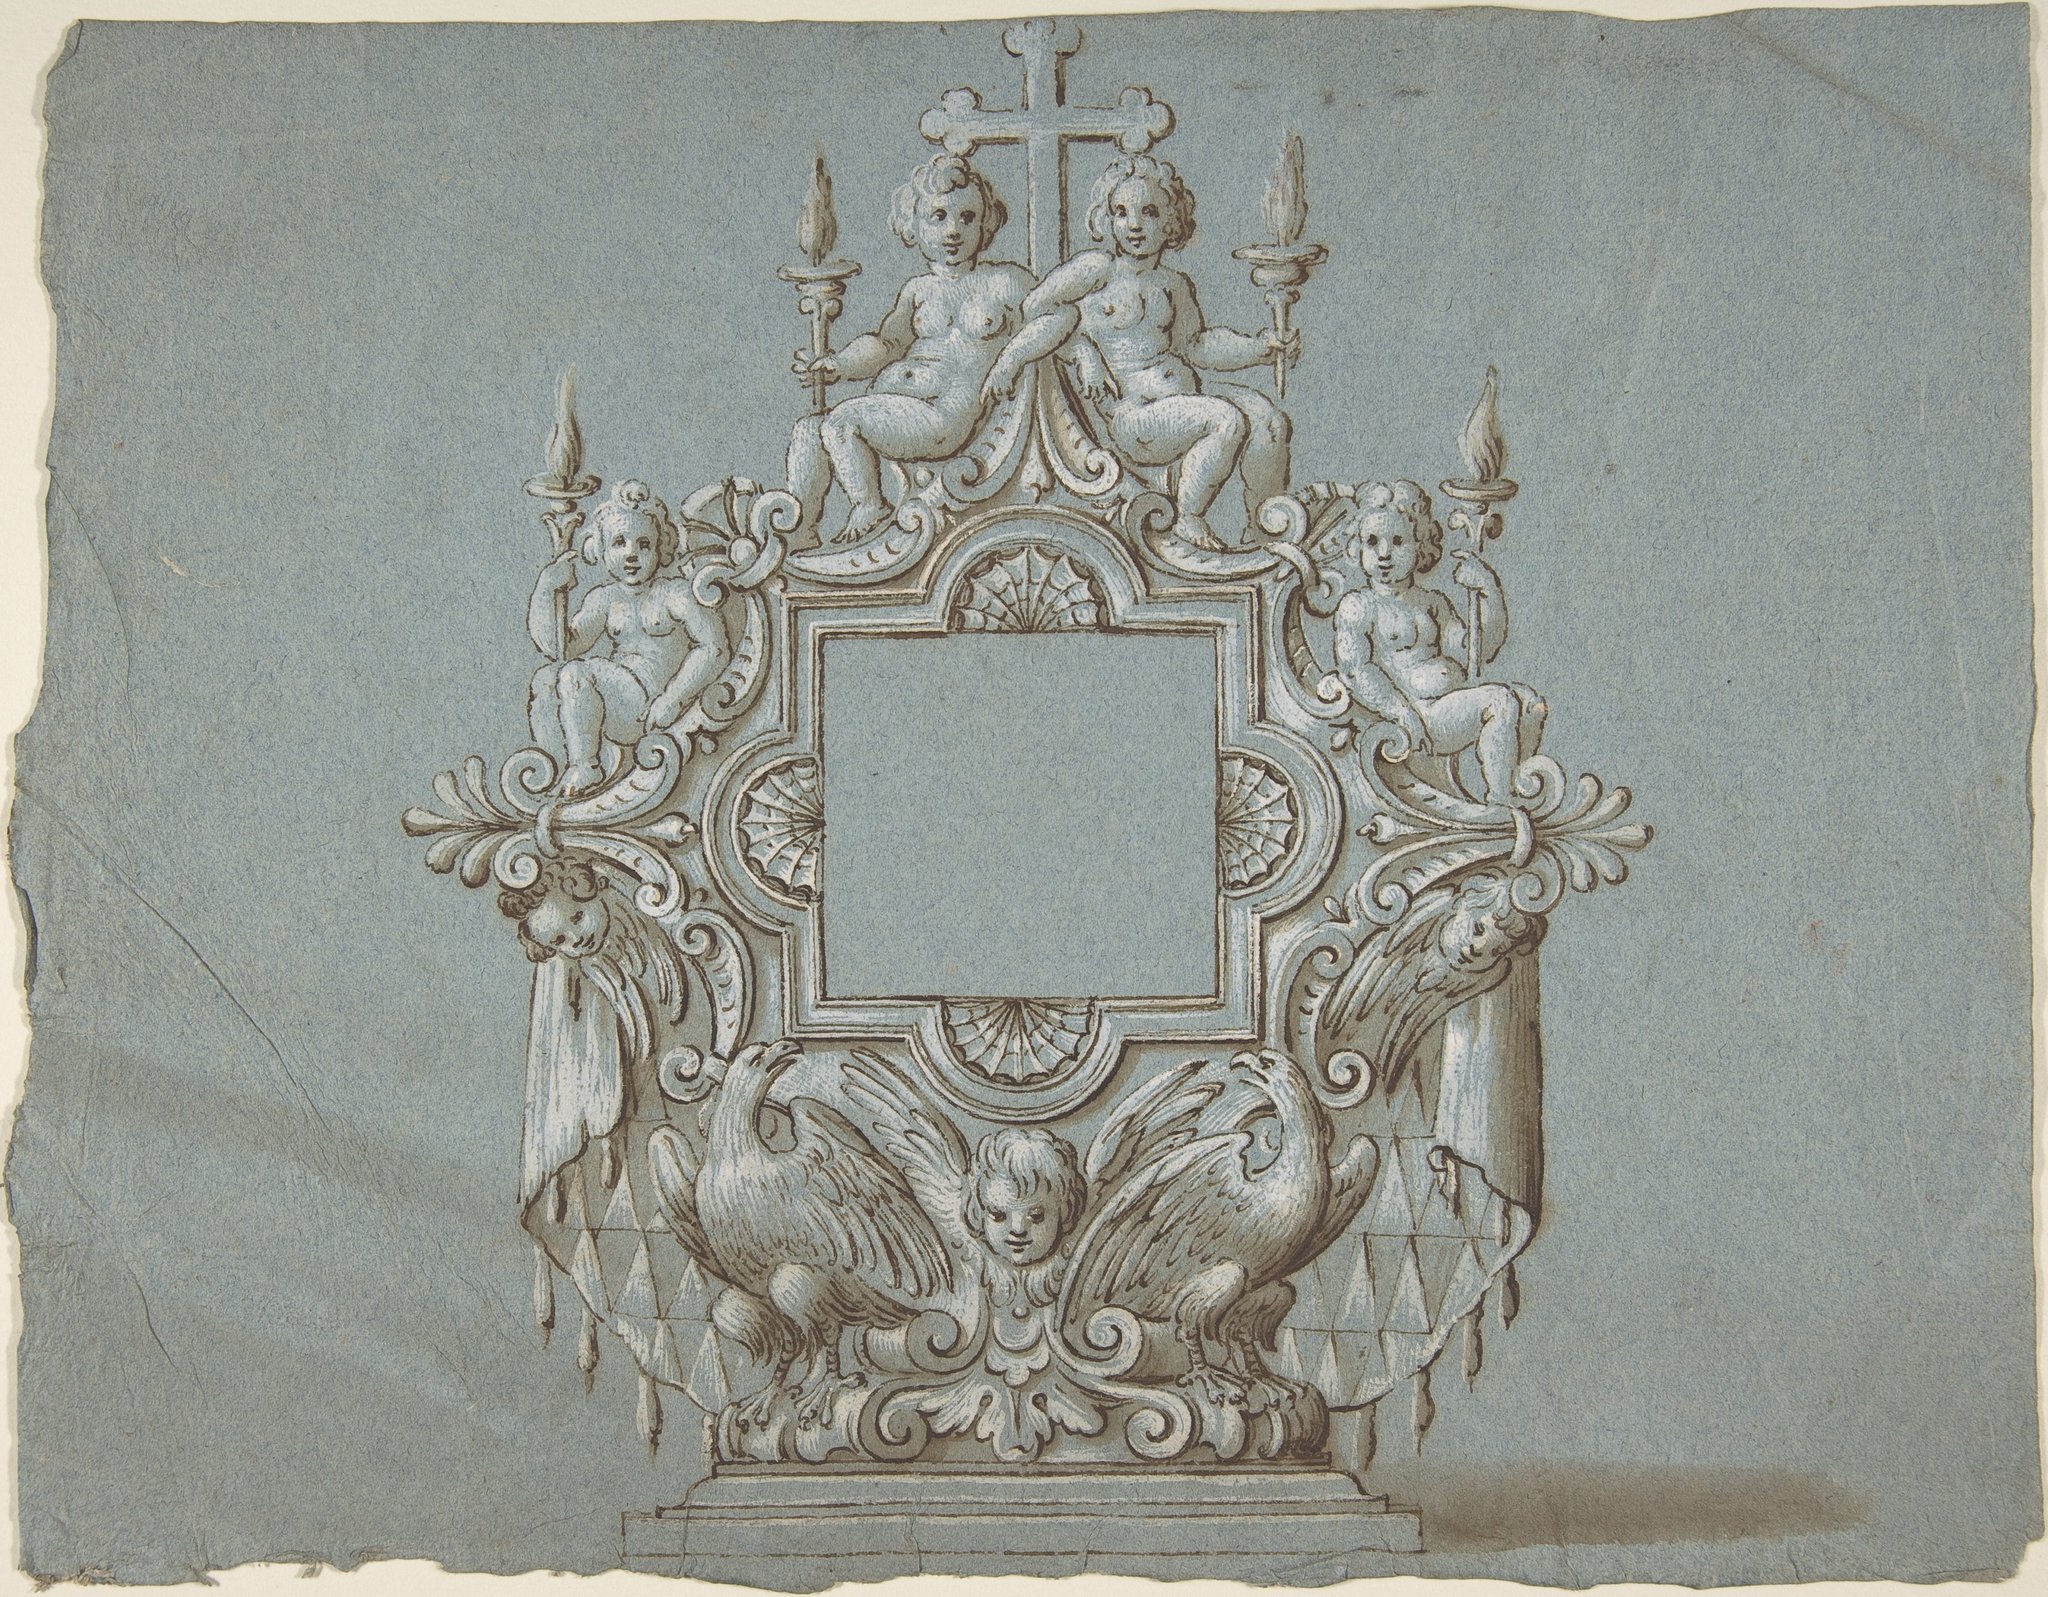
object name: drawing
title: Ornamental design for liturgical object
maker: anonymous, 18th century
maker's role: artist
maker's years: 1700-1800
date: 1701-1800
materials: gouache, ink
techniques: brush, heightening, pen, wash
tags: birds,ornament